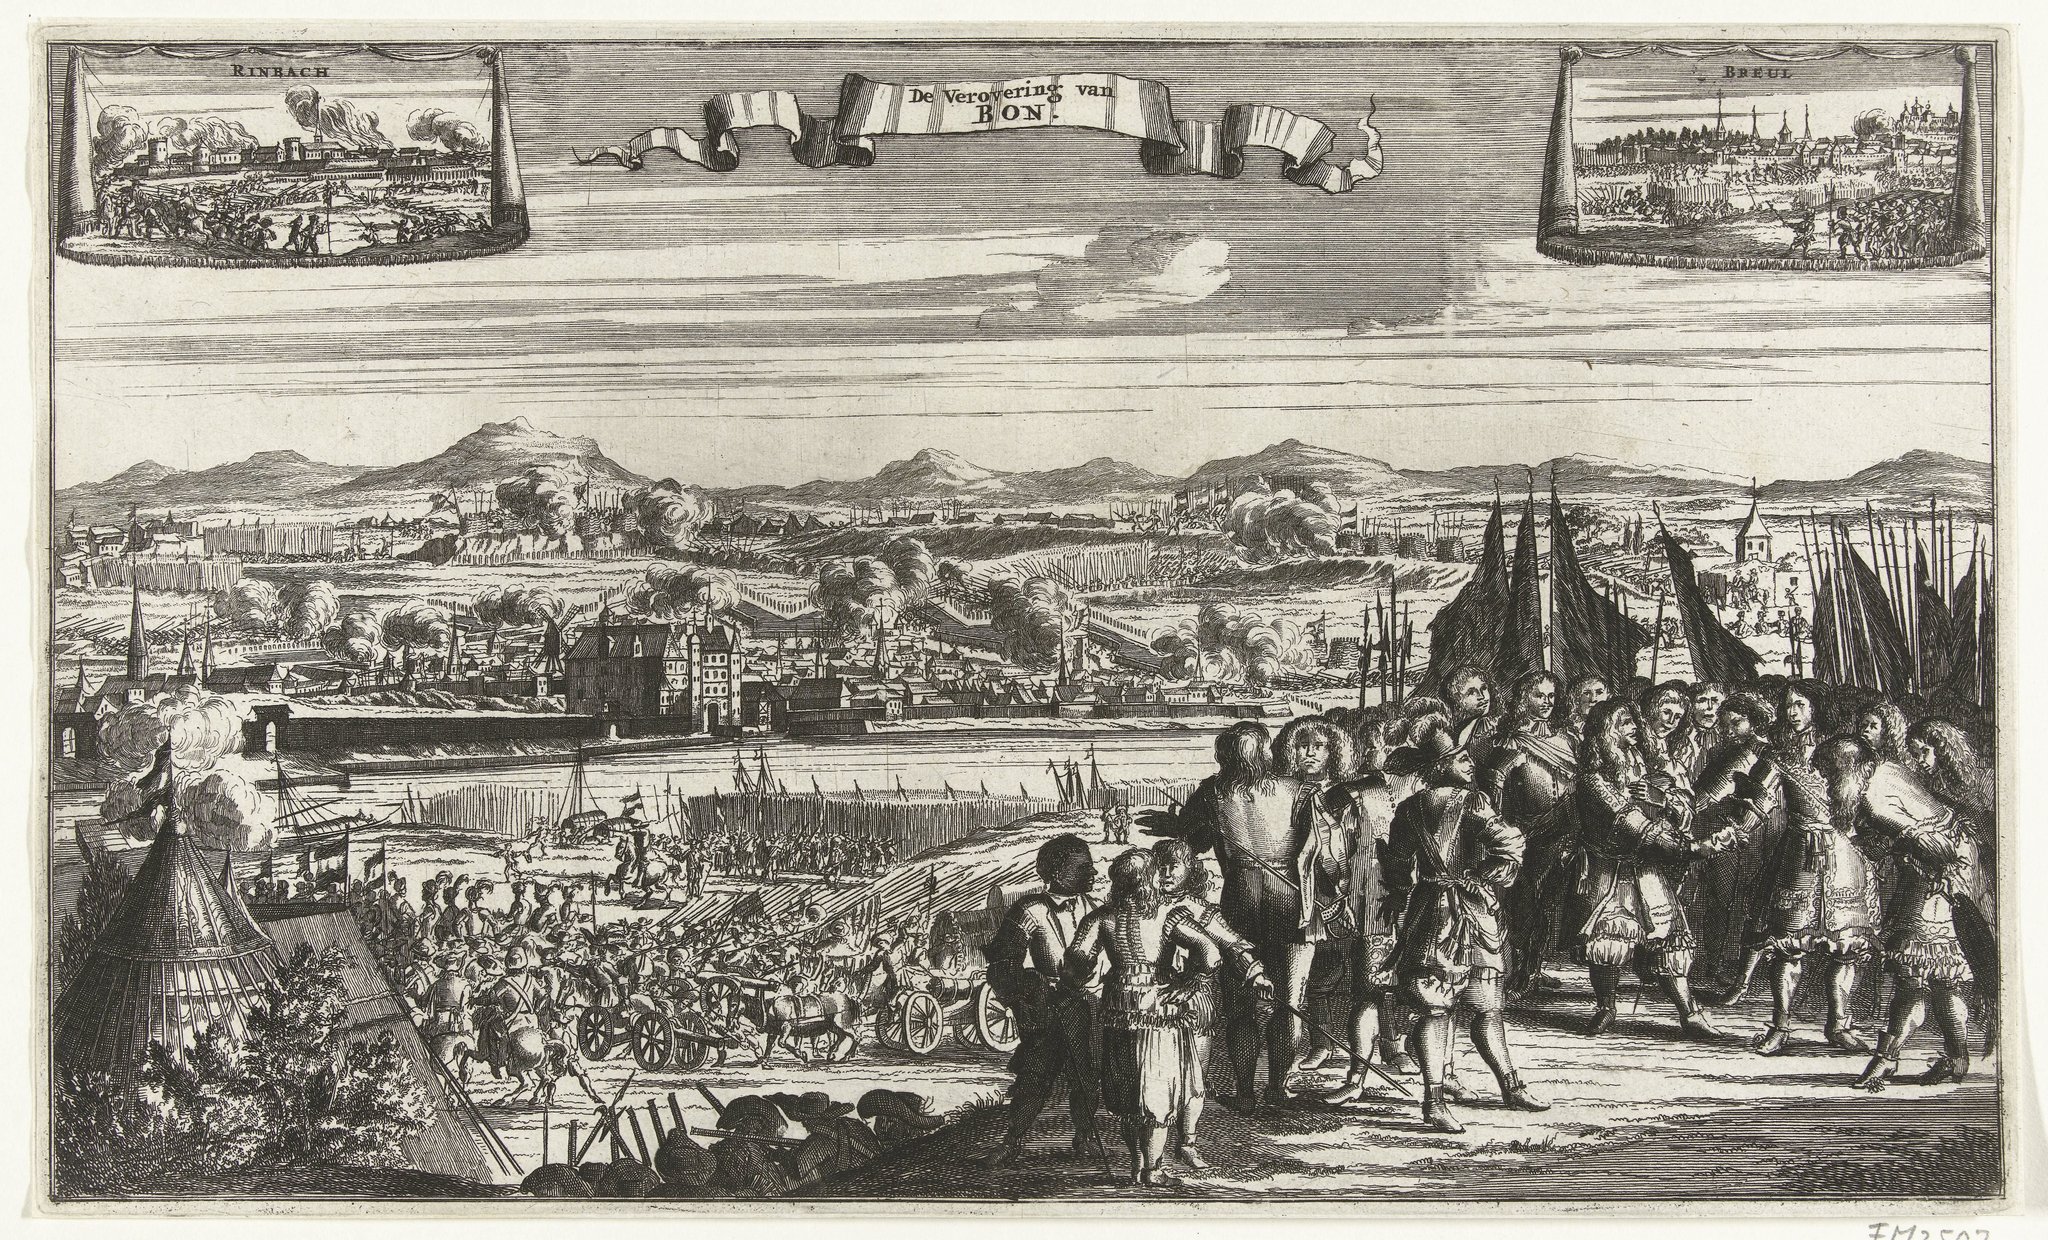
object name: print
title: De verovering van Bonn door Willem III, 1673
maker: Anonymous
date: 1673-1676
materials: paper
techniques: etching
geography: northern netherlands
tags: william iii (prince of orange and king of england, scotland, and ireland), capture of city (after the siege)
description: De verovering van Bonn door prins Willem III, 13 november 1673. Gezicht op de aan de Rijn gelegen Duitse stad. Op de voorgrond rechts feliciteren de prins en graaf Montecuccoli elkaar. Bovenaan in de hoeken twee kleine voorstellingen van de veroveringen van Rheinbach en Brühl.